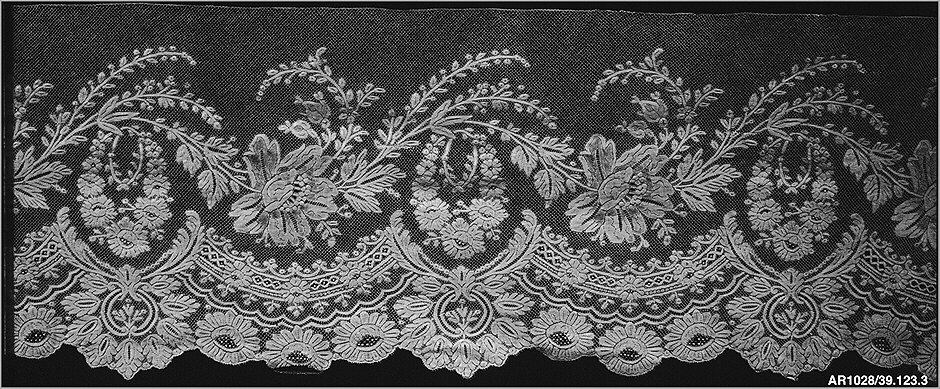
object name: piece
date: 1801-1900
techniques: lace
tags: flowers,leaves